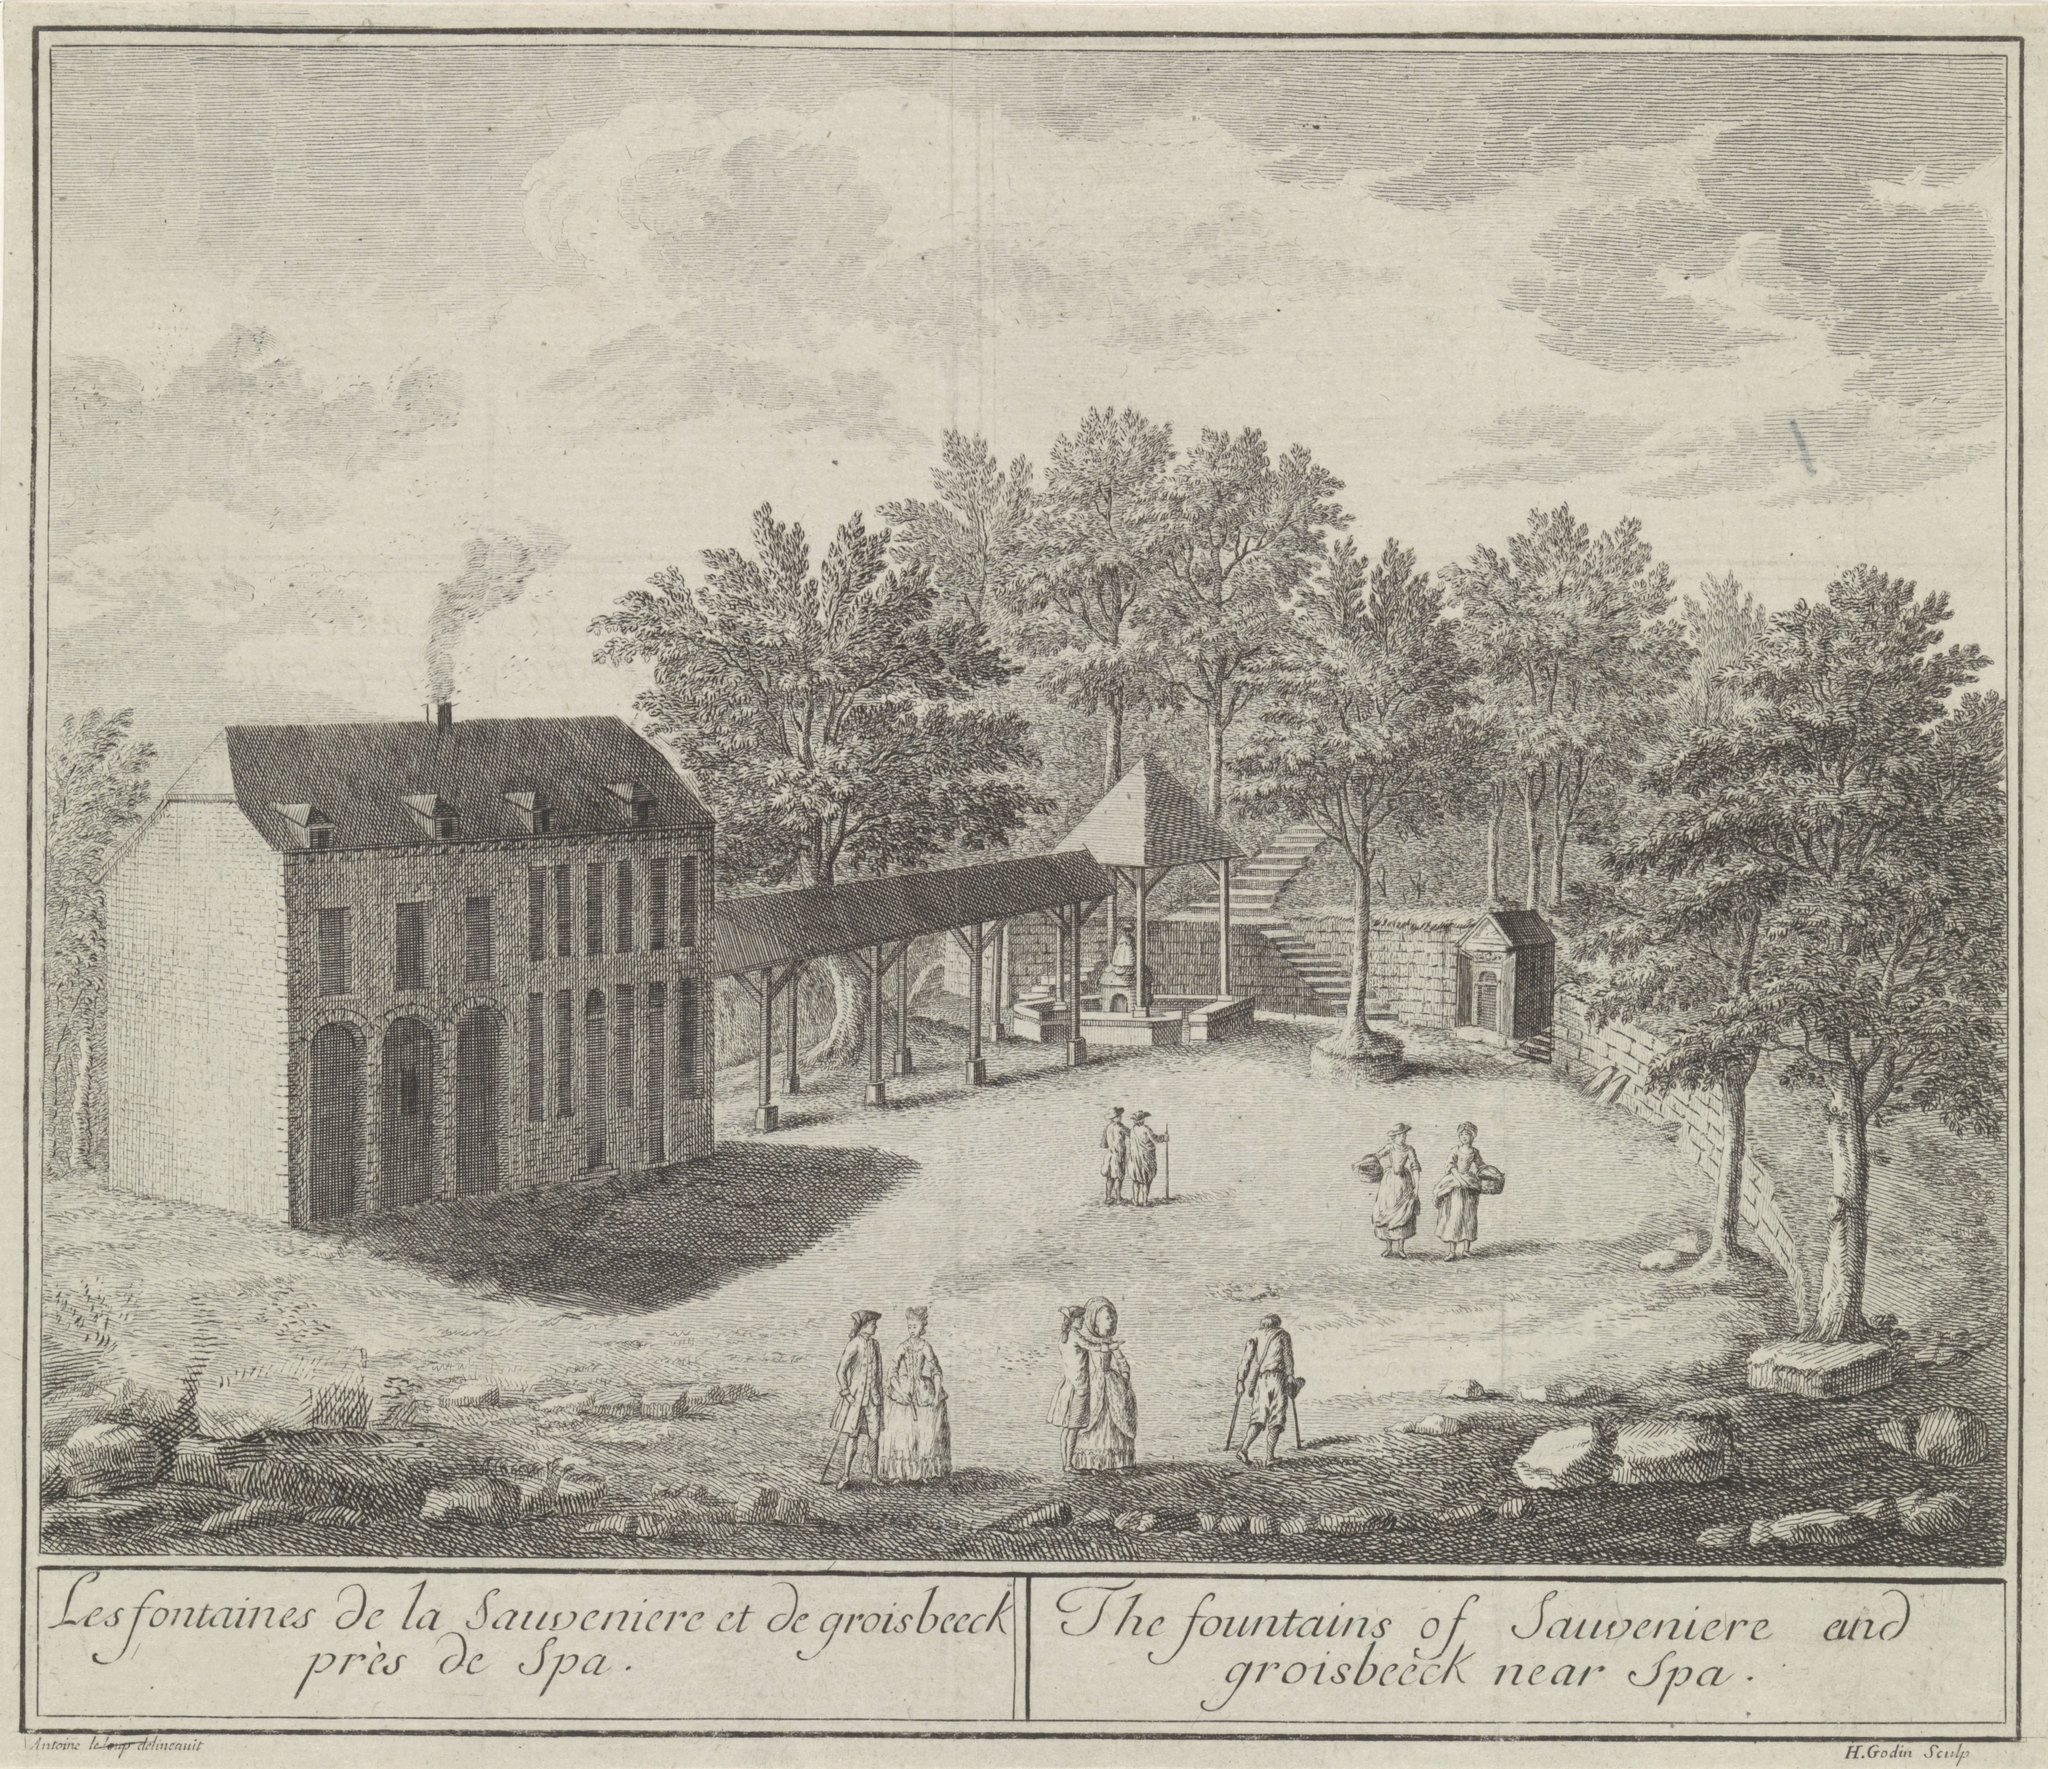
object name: print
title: Gezichten in en nabij Spa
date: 1778-1782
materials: paper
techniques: engraving, etching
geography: liège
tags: watering-place, spa, spring, source of river or stream (+ landscape with figures, staffage)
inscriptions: collector's mark: Lugt 2228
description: De baden nabij de bronnen van Sauveniere en van Groesbeek bij Spa. Op de voorgrond enkele bezoekers. De prent is deel van een serie met landschappen in en nabij Spa